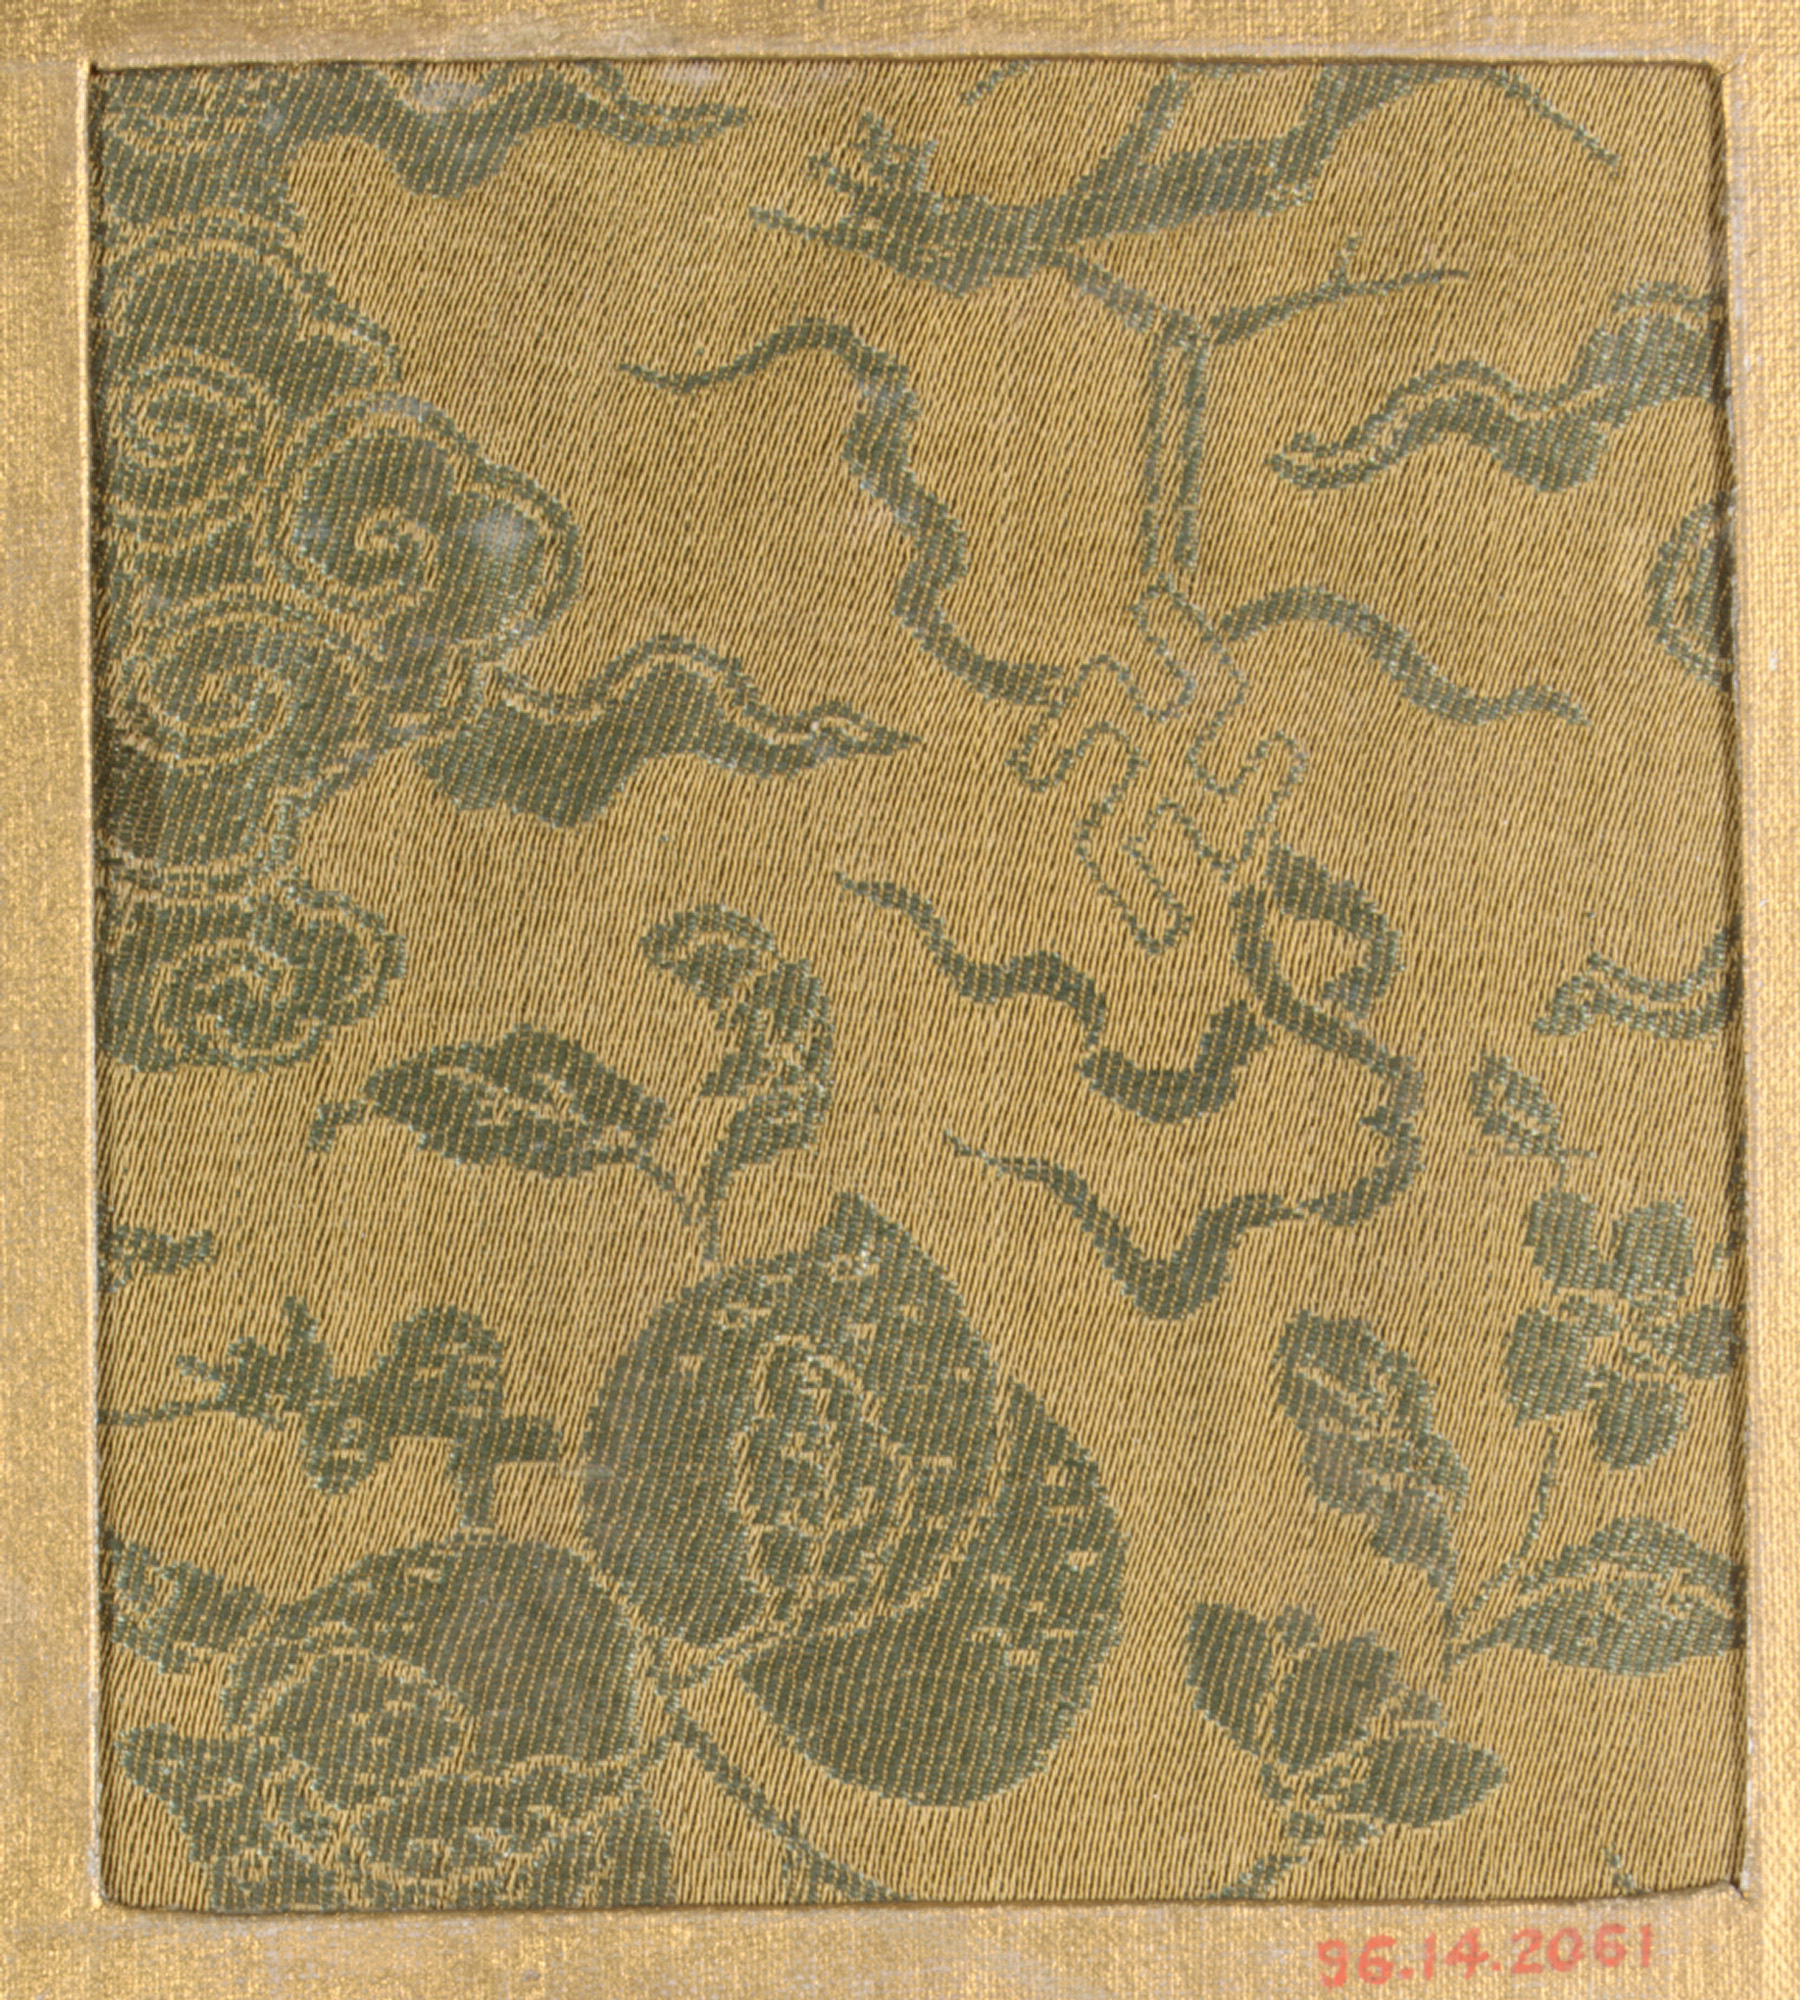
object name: piece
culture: chinese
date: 1701-1900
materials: silk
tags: snakes,leaves